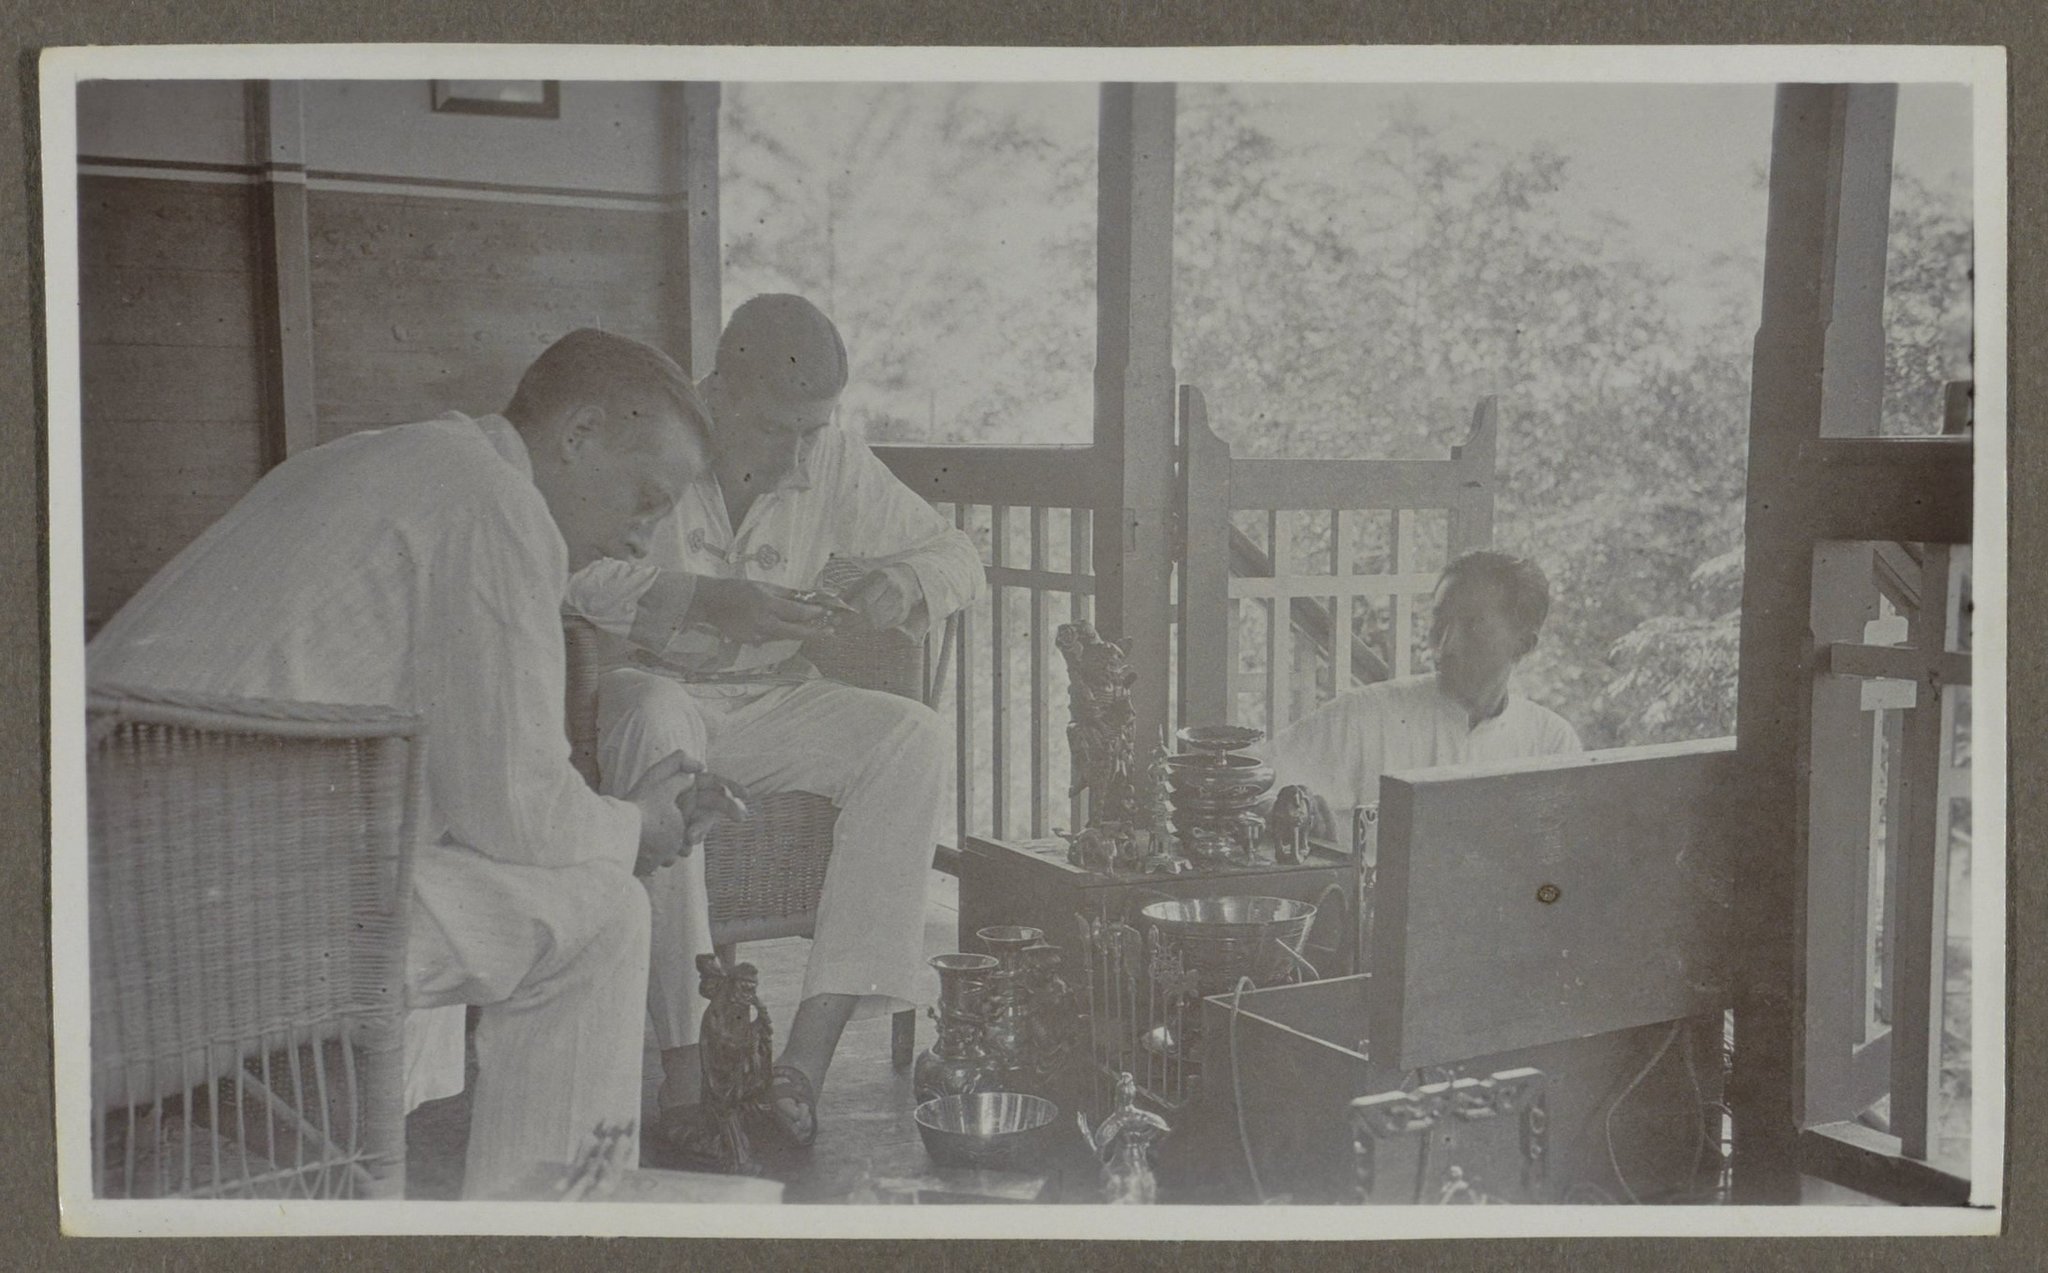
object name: photograph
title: Twee mannen bekijken de handelswaar van een Indische verkoper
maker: Anonymous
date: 1920-1930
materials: photographic support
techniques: gelatin silver print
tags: wandering or travelling merchant, dutch east indies, the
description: Twee mannen zitten op een veranda. Op de trap een Indische verkoper. Hij heeft zijn koopwaar, waaronder bewerkte metalen vazen en schalen, voor hen uitgestald. Onderdeel van familiealbum Nederlands-Indië.